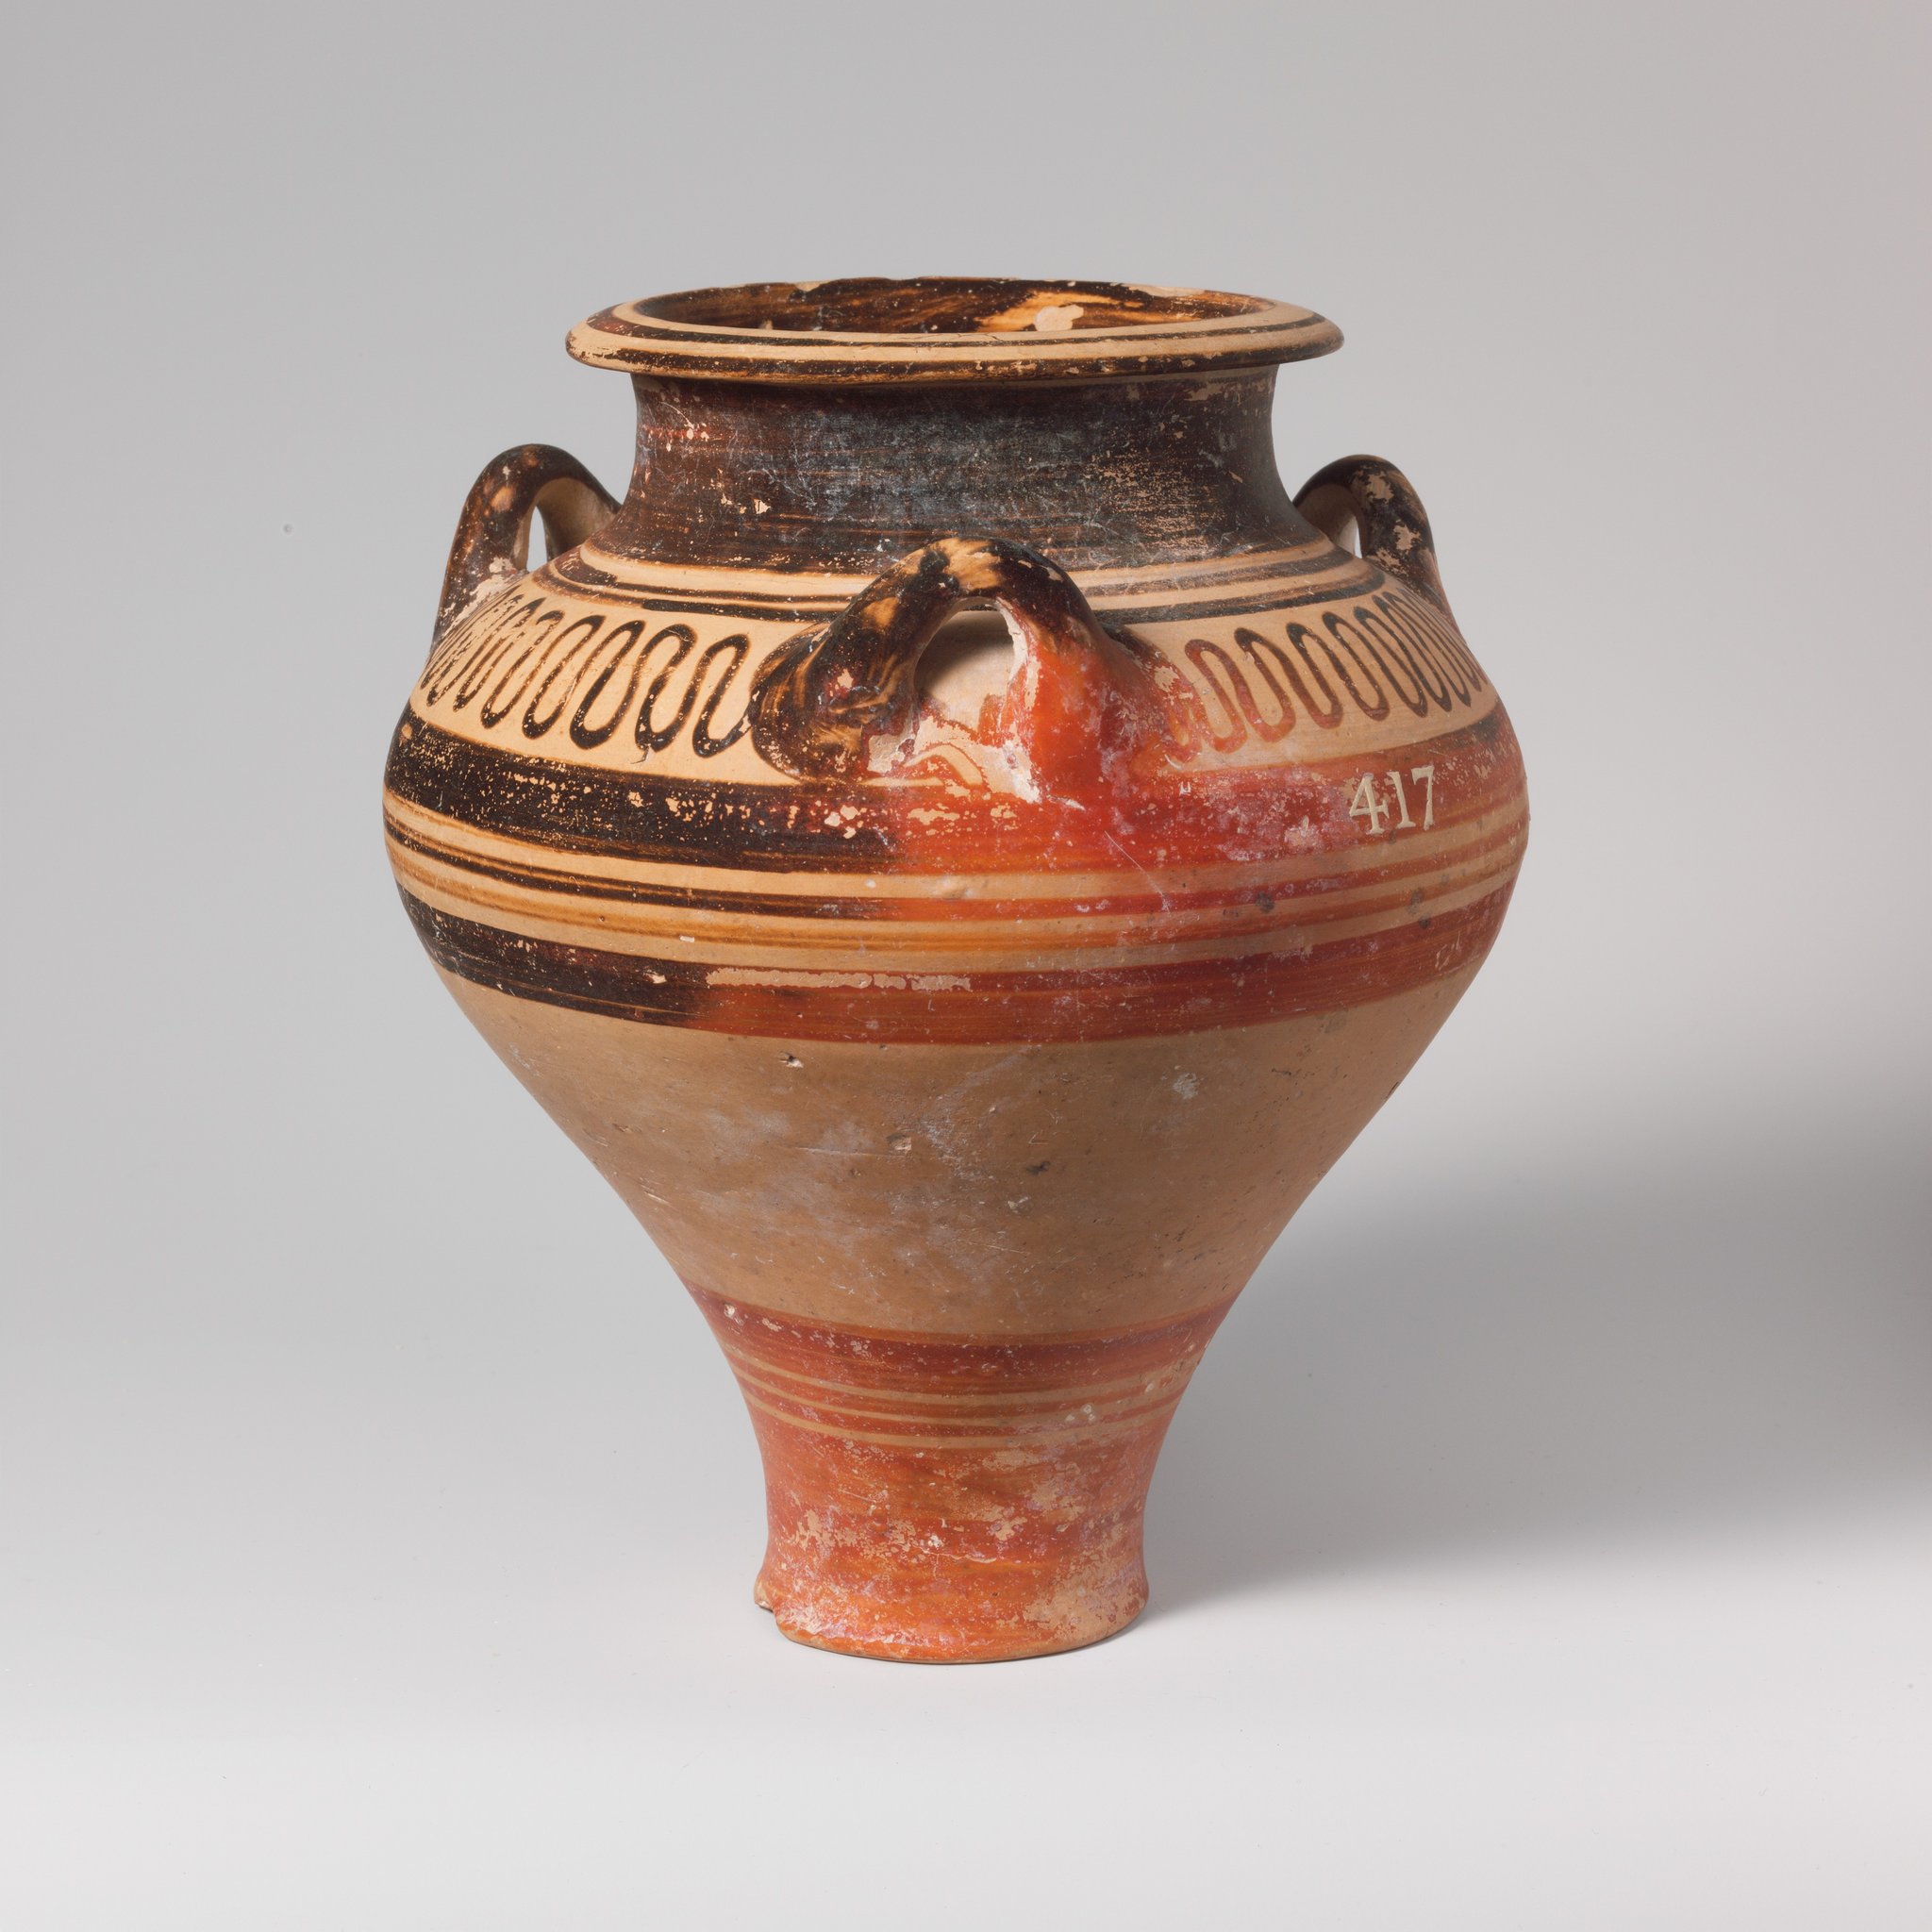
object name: vase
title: Terracotta pithoid jar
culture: mycenaean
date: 1400-1050 BCE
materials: terracotta